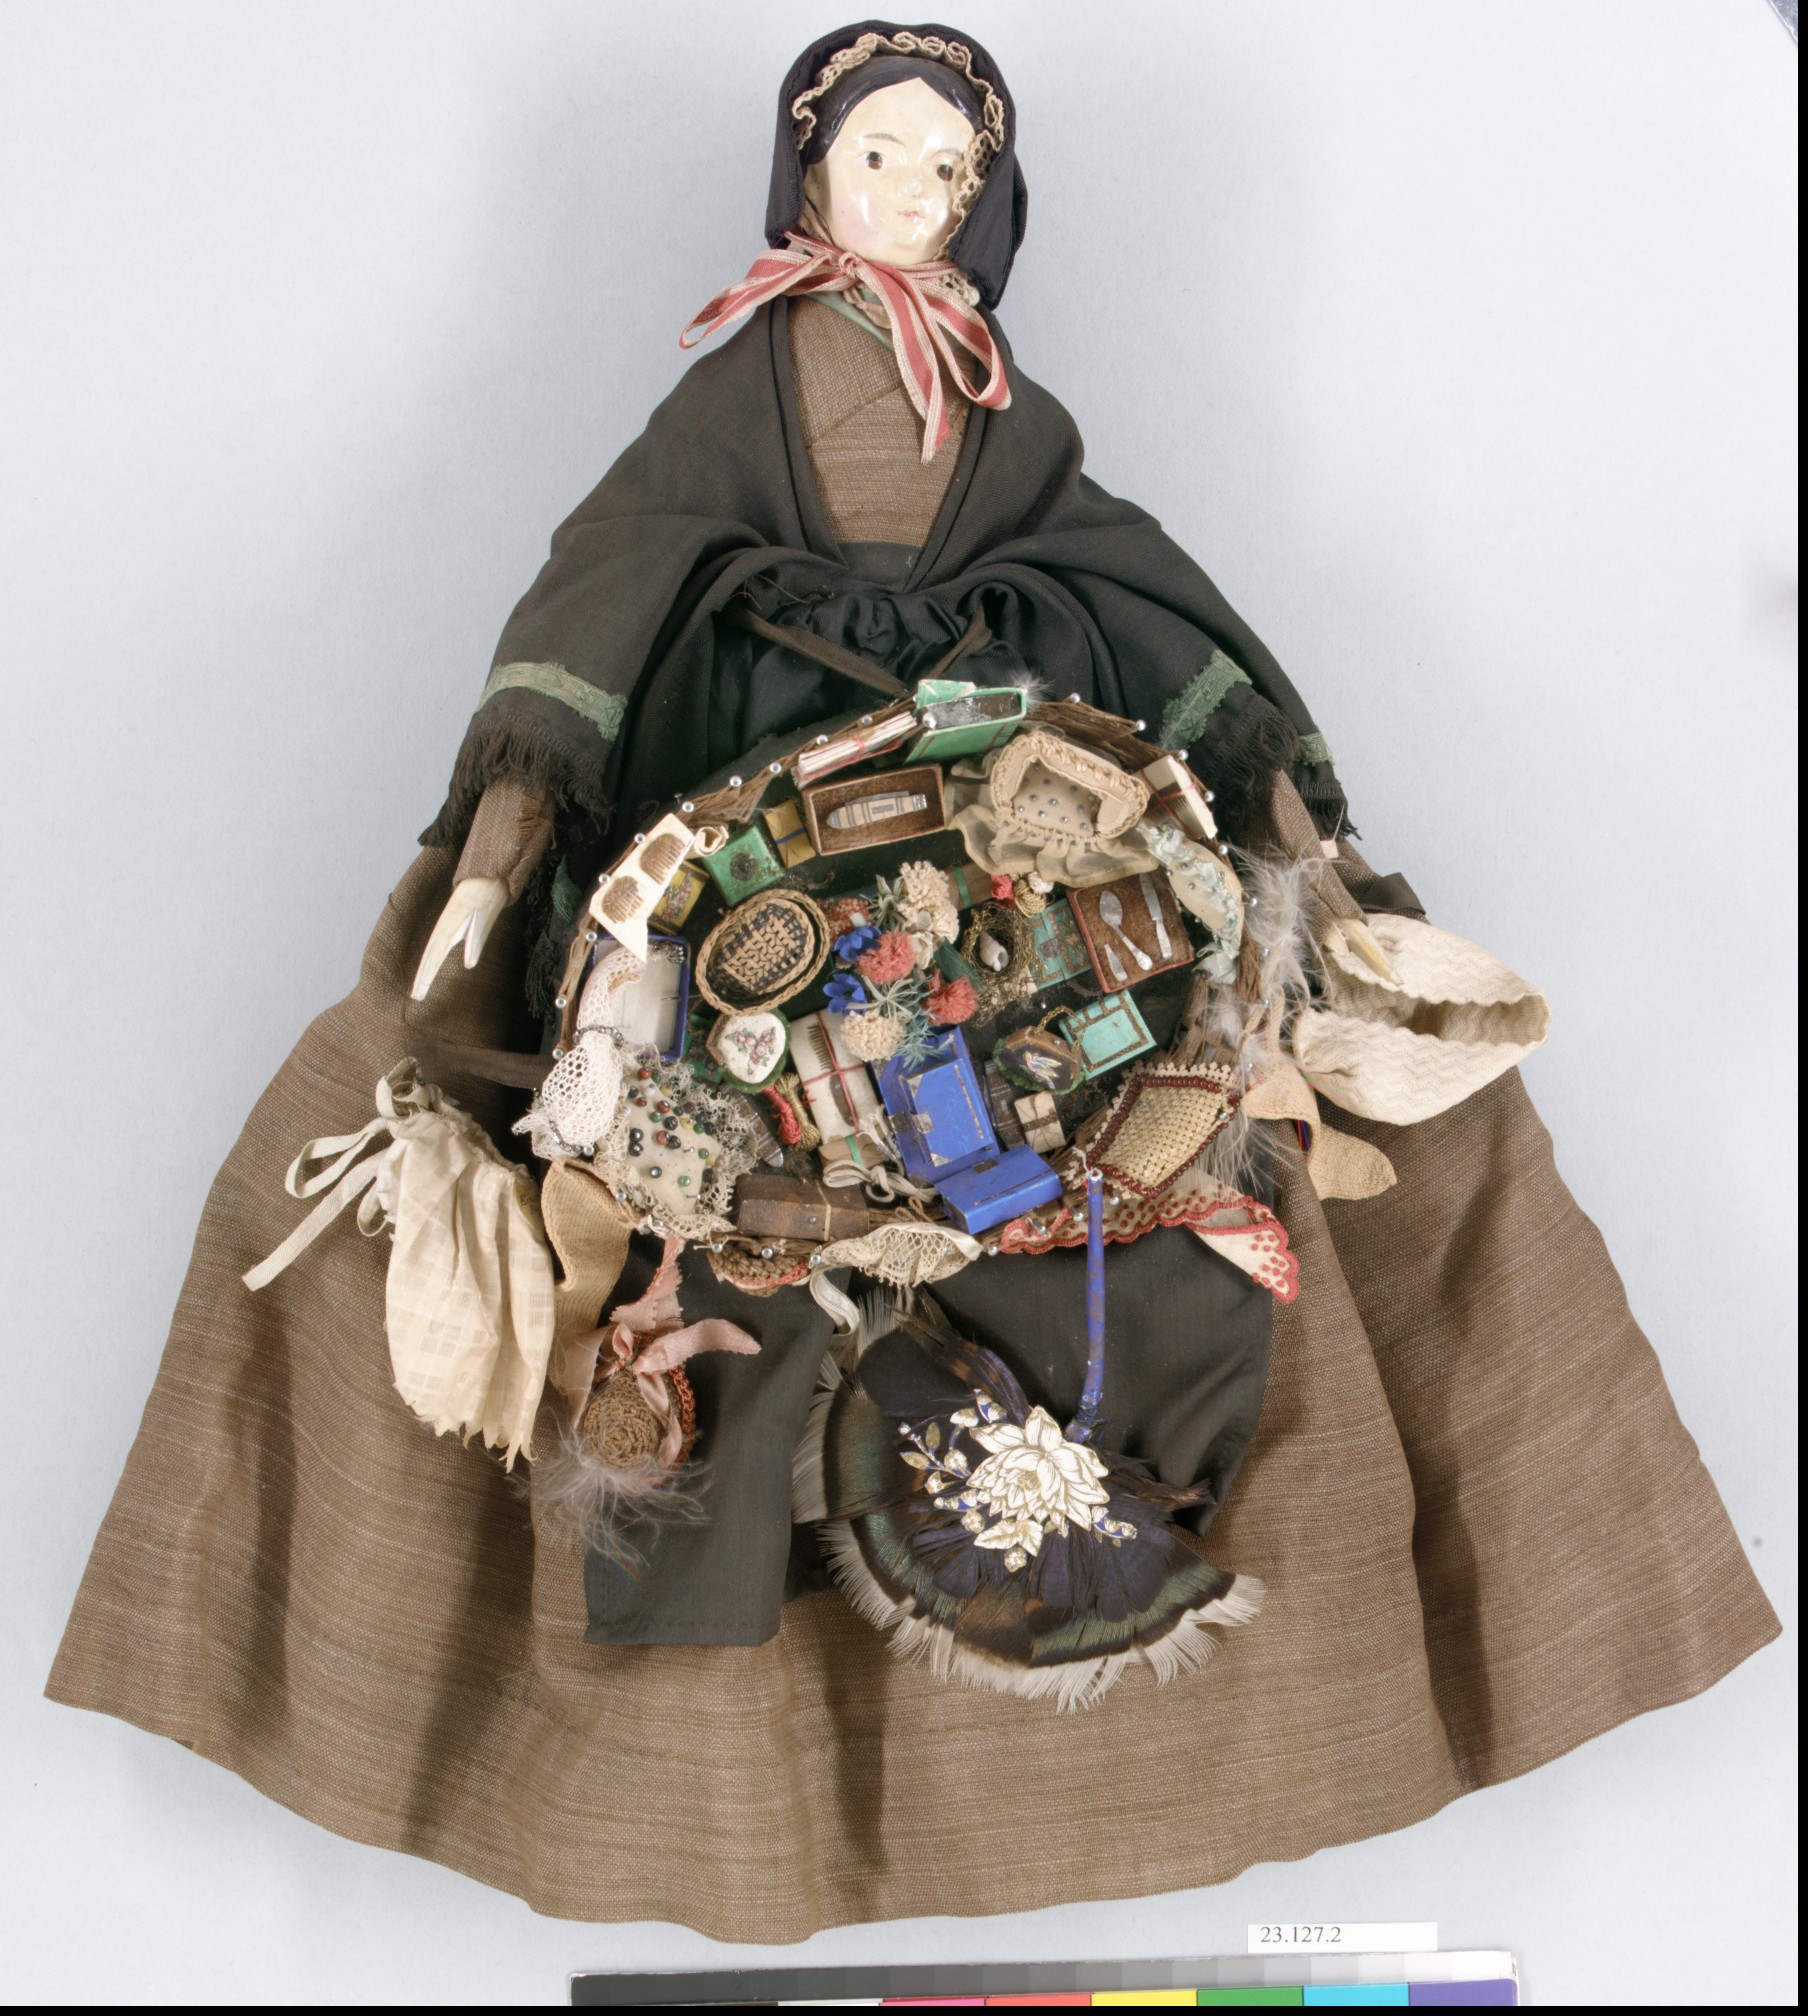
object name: doll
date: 1870